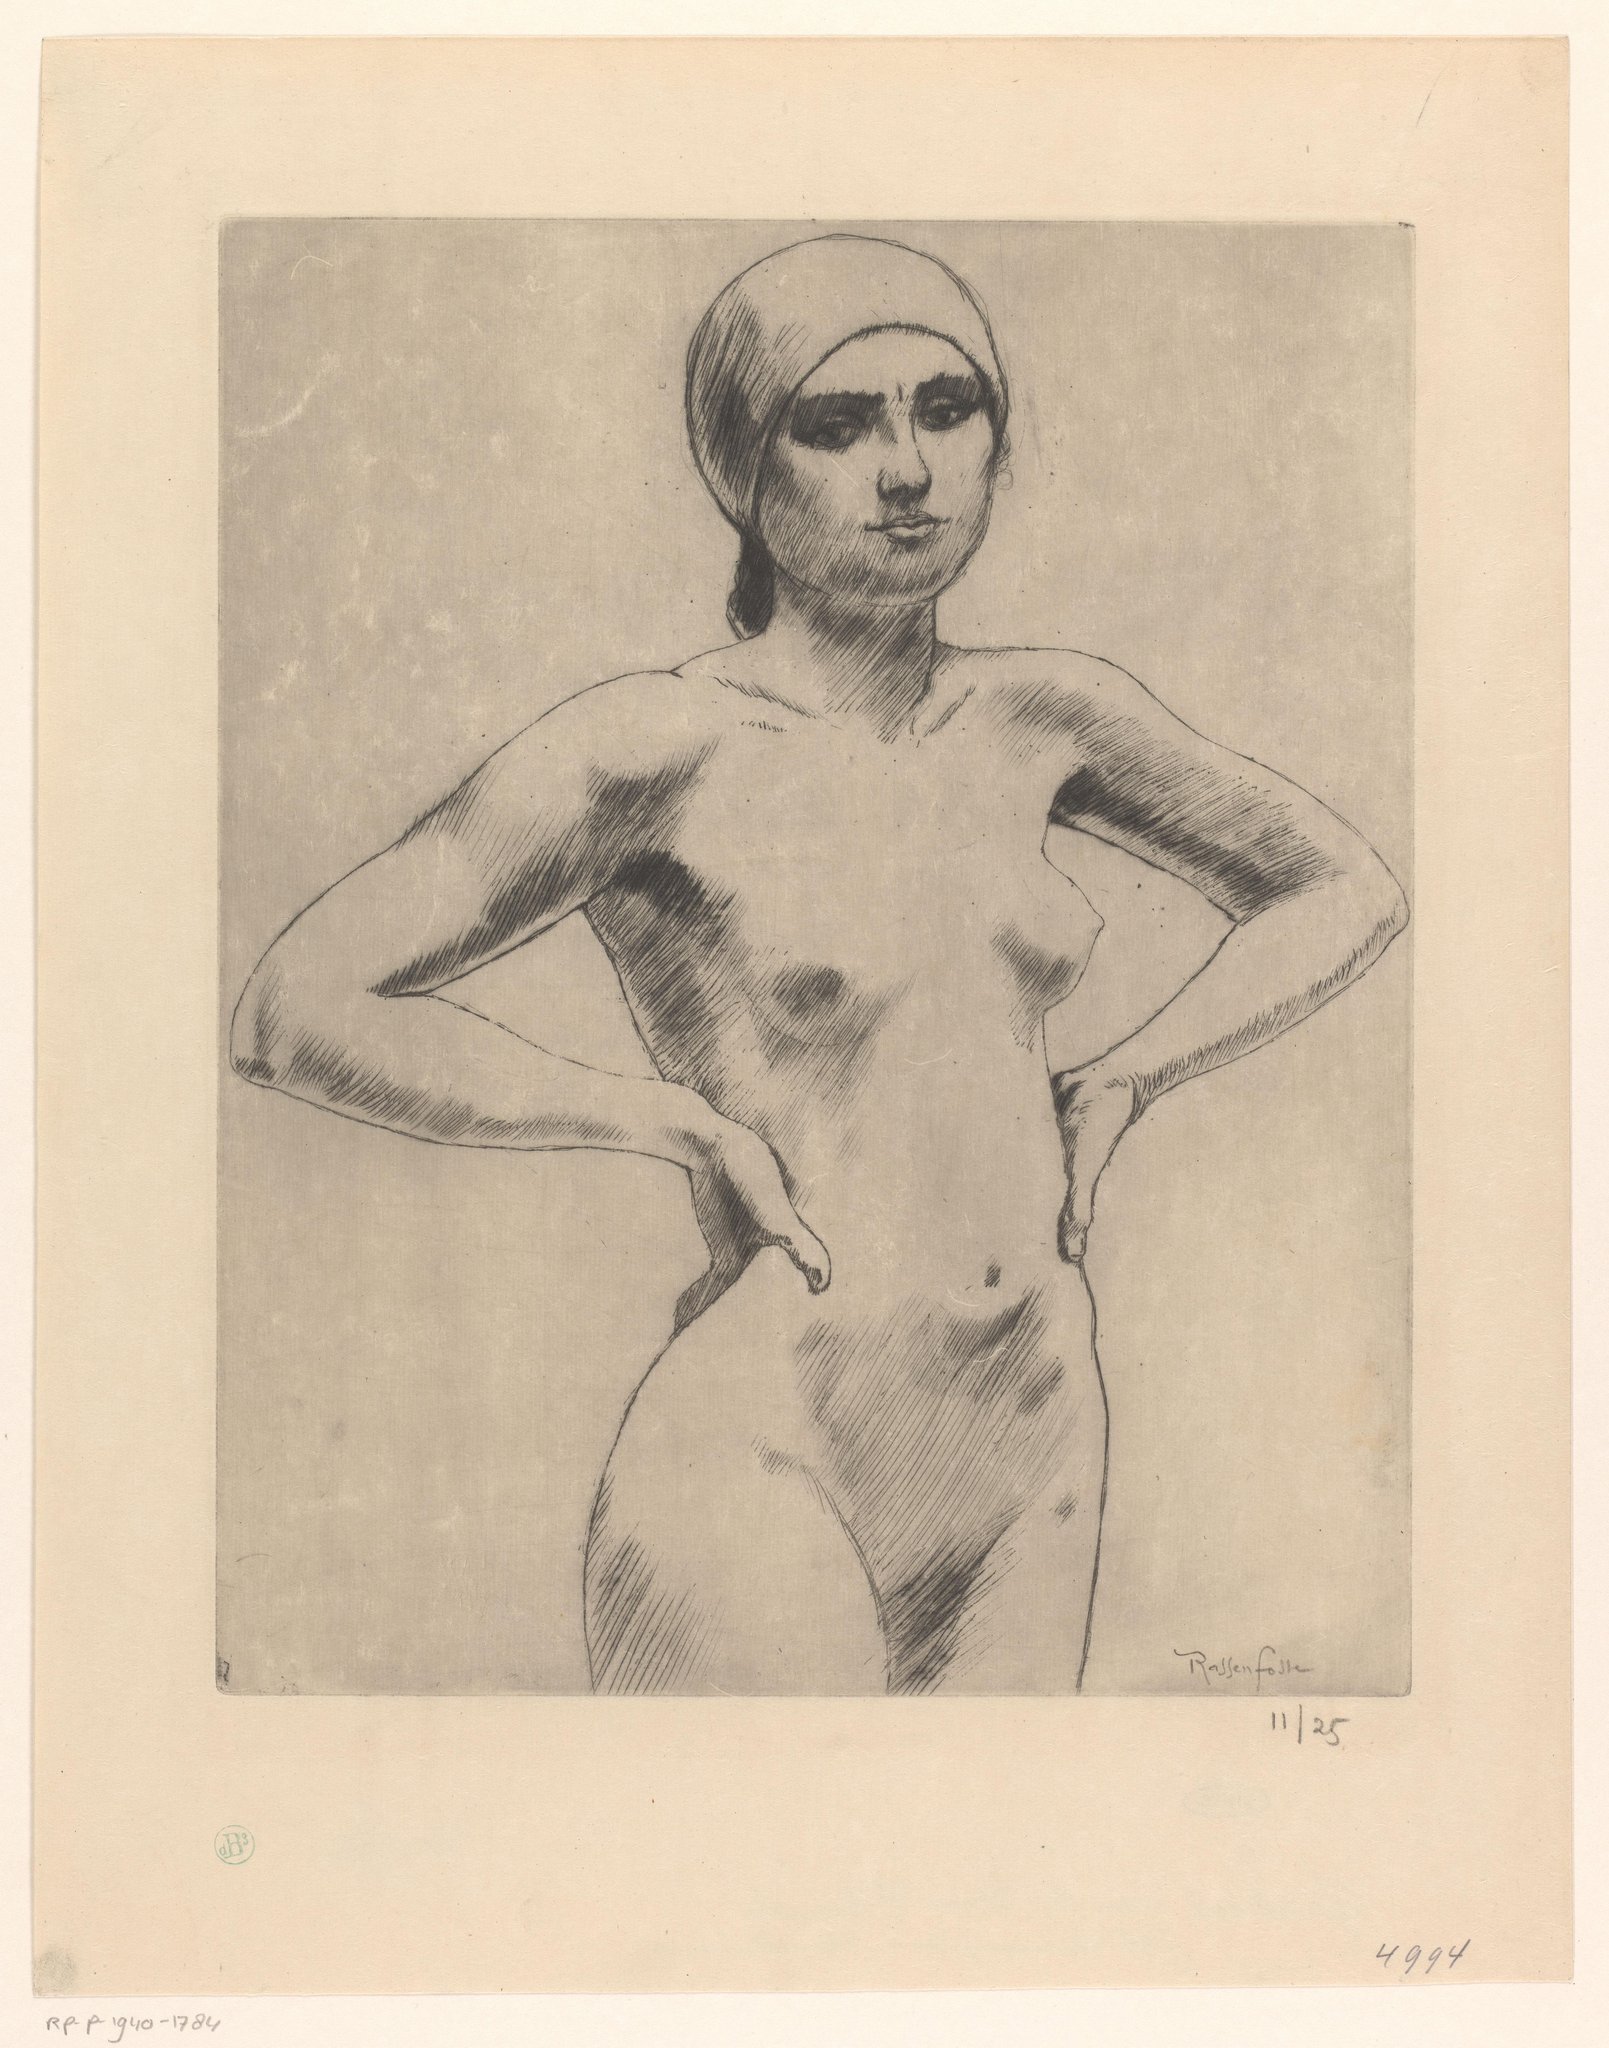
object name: print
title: Naakte vrouw met armen in haar zij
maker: armand rassenfosse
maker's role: draughtsman, painter, print maker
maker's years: 1862-1934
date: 1872-1934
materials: paper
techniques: drypoint, etching, intaglio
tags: adolescent, young woman, maiden, head-gear, woman (showing herself) undressed, quasi-nude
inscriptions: collector's mark: Lugt 733, collector's mark: Lugt 2228